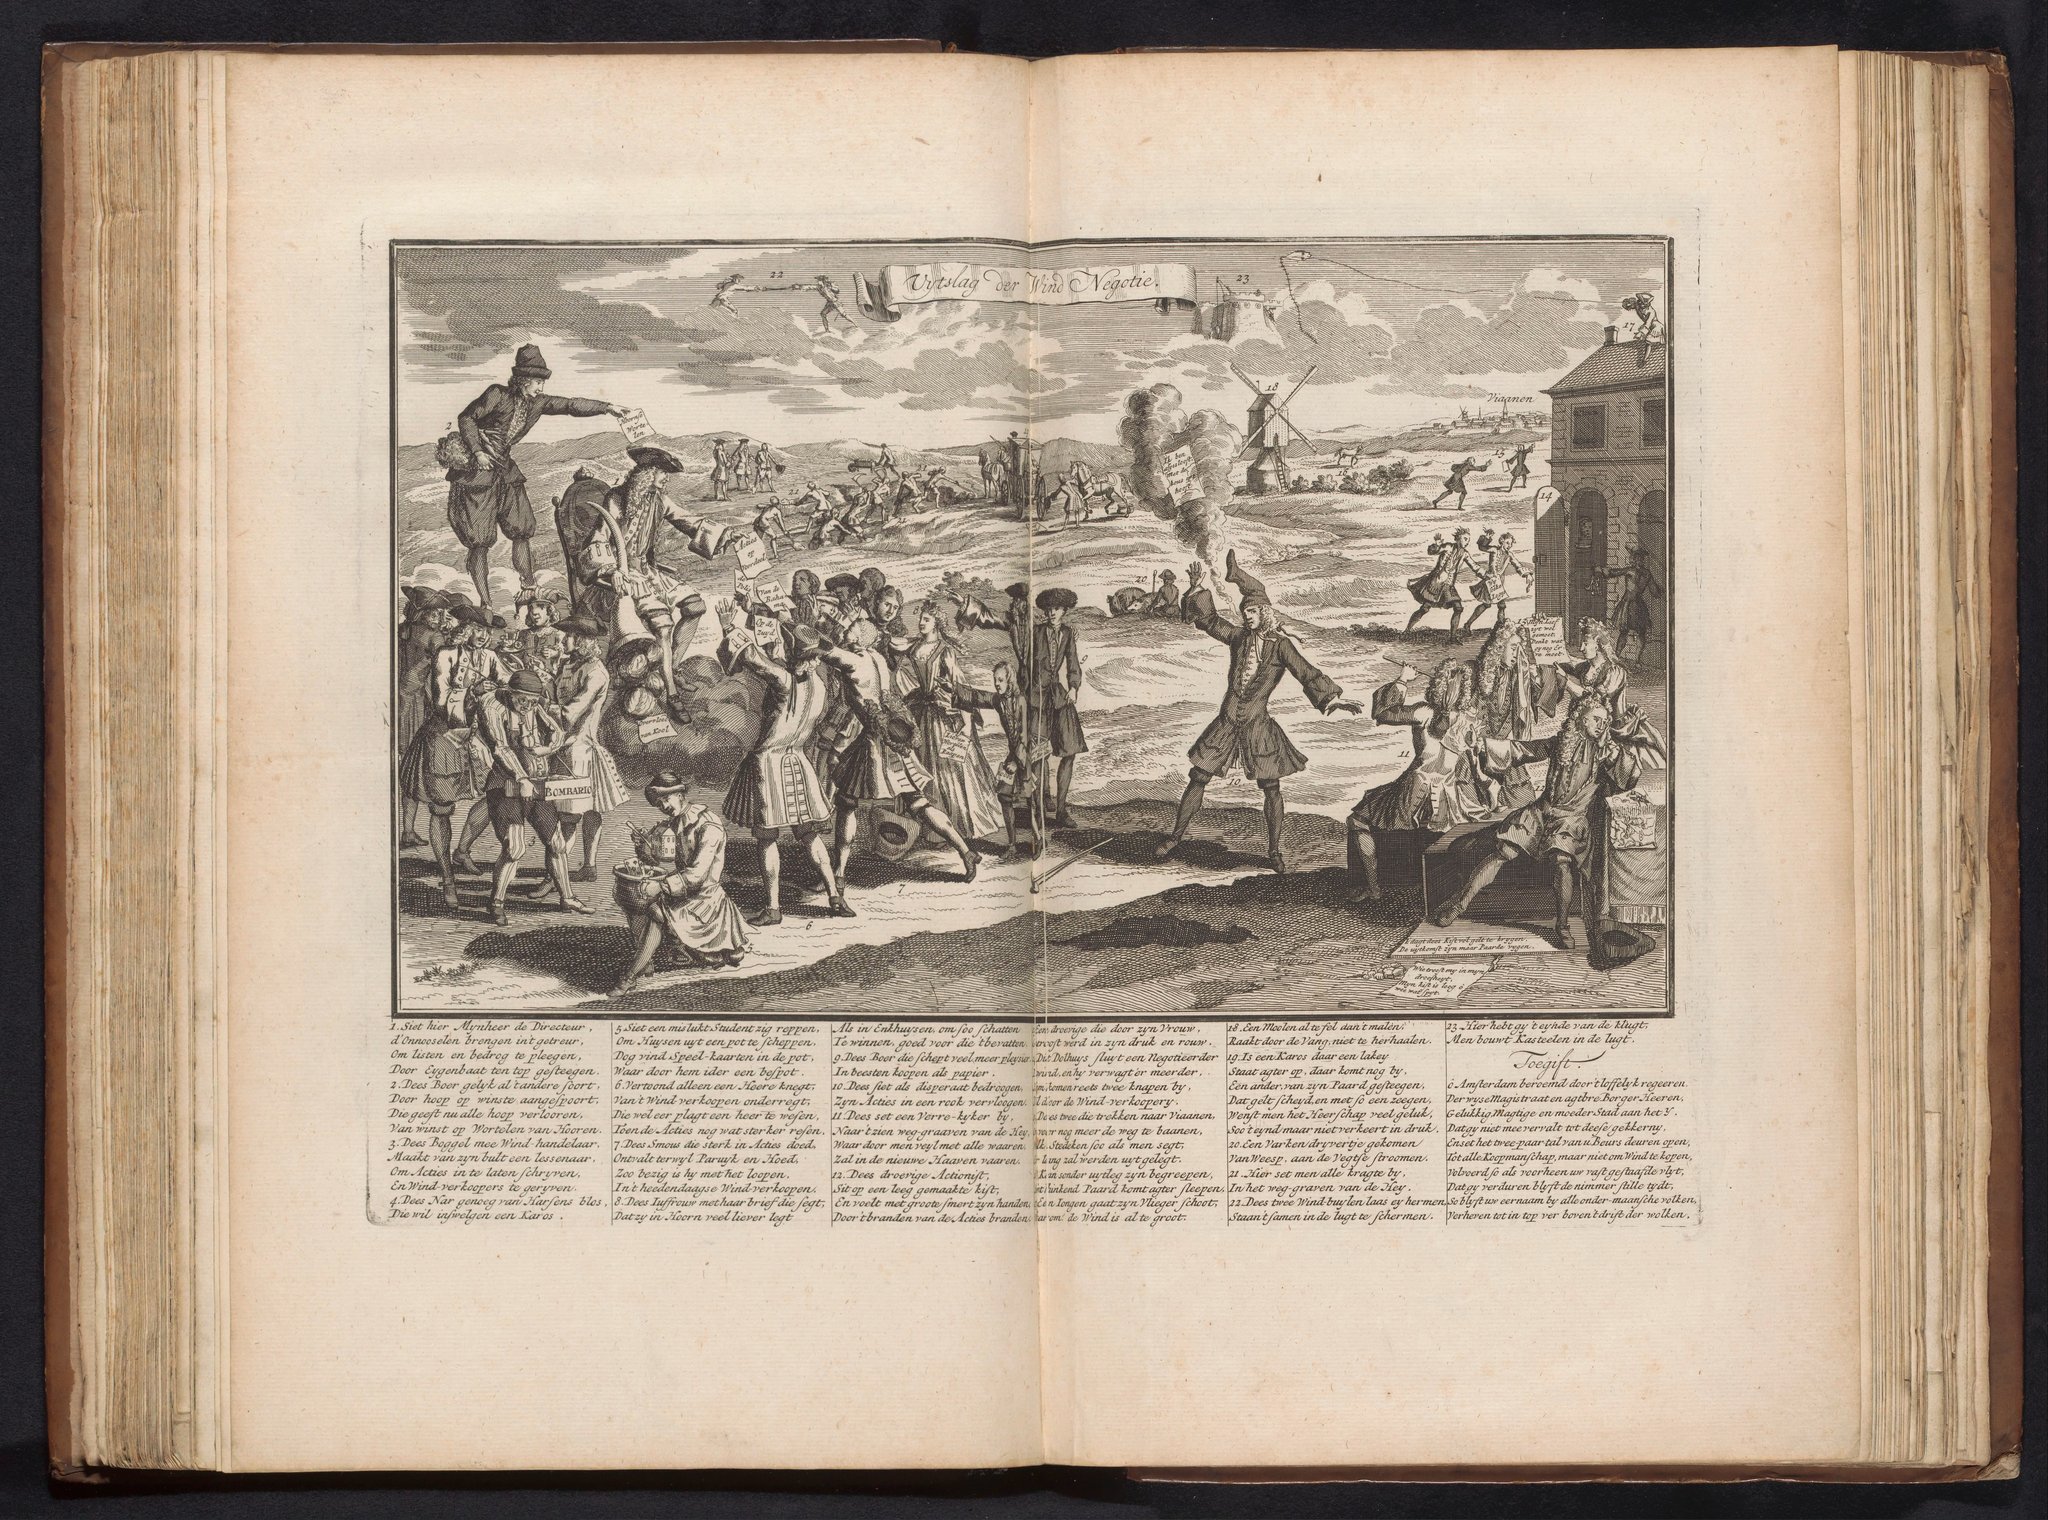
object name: print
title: Uitslag van de windnegotie, 1720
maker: Anonymous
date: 1720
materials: paper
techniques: etching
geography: northern netherlands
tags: financial panic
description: Spotprent op de windhandel van John Law, 1720. Law zittend op een stoel dat zweeft op de wind met een hoorn van overvloed en deelt acties uit. Rechts het dolhuis, in het midden een man met de kous op de kop. Op de achtergrond Vianen en wordt er gewerkt aan het Utrechtse kanaal. In het onderschrift een uitleg van de cijfers 1-23 in rijm. Prent in de gebonden eerste uitgave (304 B 11) van Het Groote Tafereel der Dwaasheid met spotprenten op de Windhandel of Actiehandel van 1720.